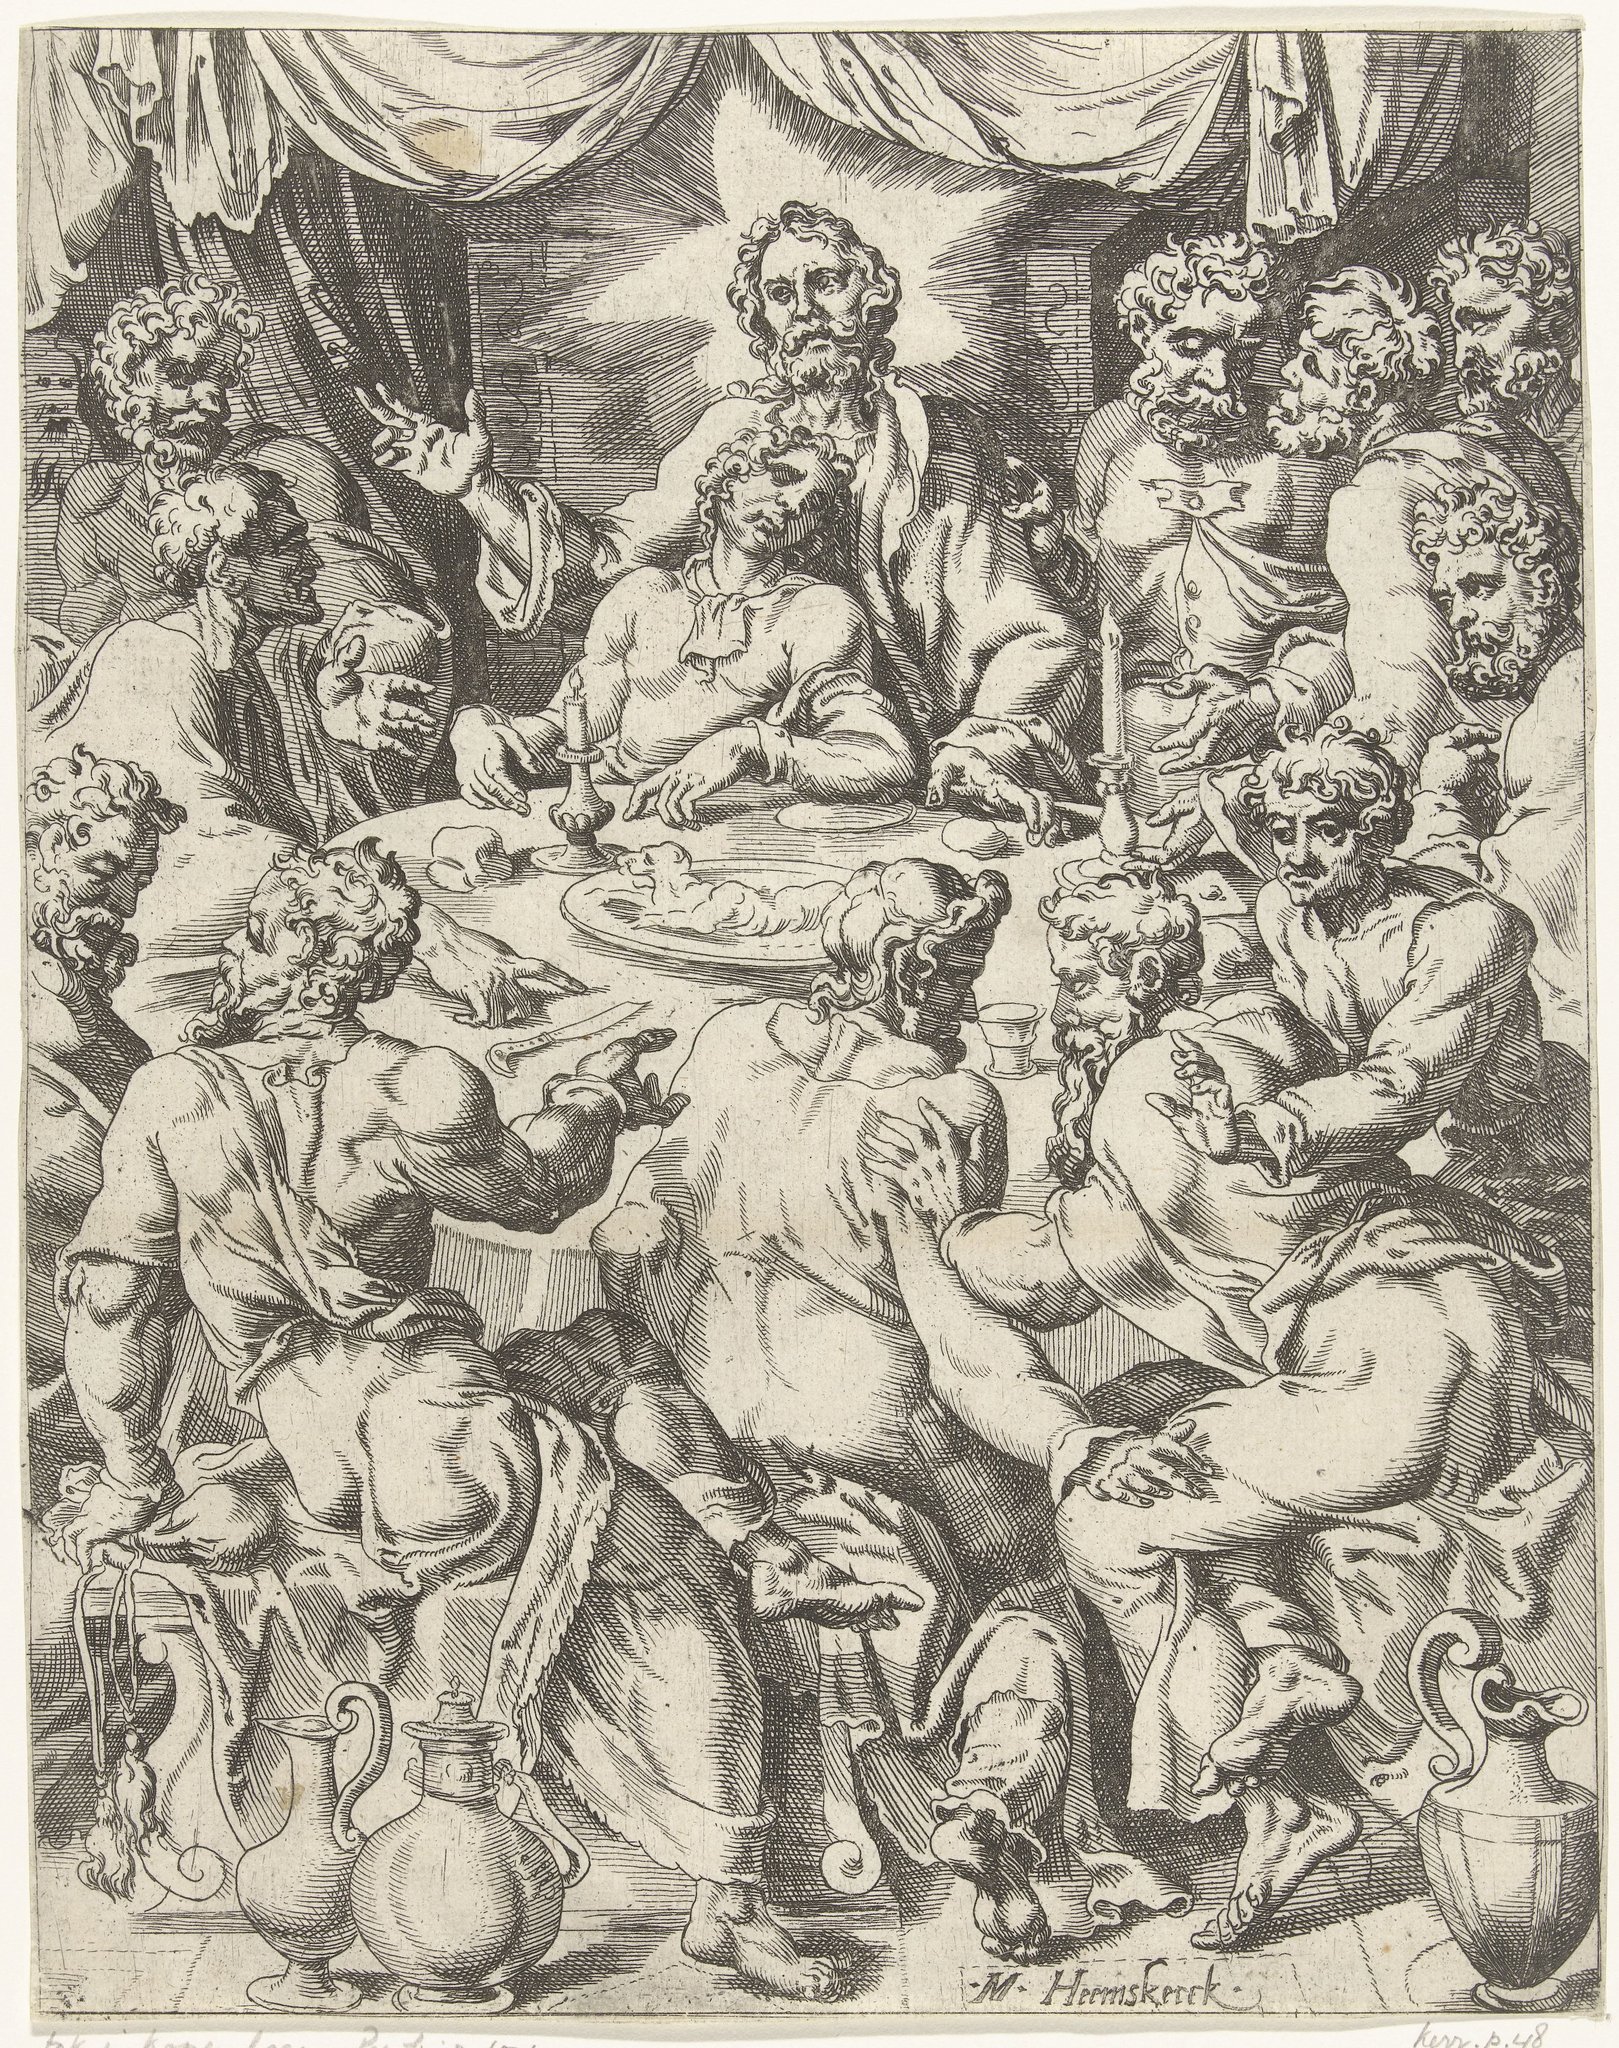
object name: print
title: Val en de verlossing van de mensheid door het leven en passie van Christus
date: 1548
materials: paper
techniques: etching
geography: haarlem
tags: last supper (in general) (matthew 26:21-35; mark 14:18-31; luke 22:3, 22:15-23; john 13:21-38)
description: Christus en zijn leerlingen rondom een ronde tafel. Christus vertelt zijn apostelen dat een van hen hem zal verraden. De apostelen verwerpen de voorspelling van Christus en discussiëren met elkaar. De prent is deel van een dertigdelige serie met prenten over de zondeval en Christus' passie.